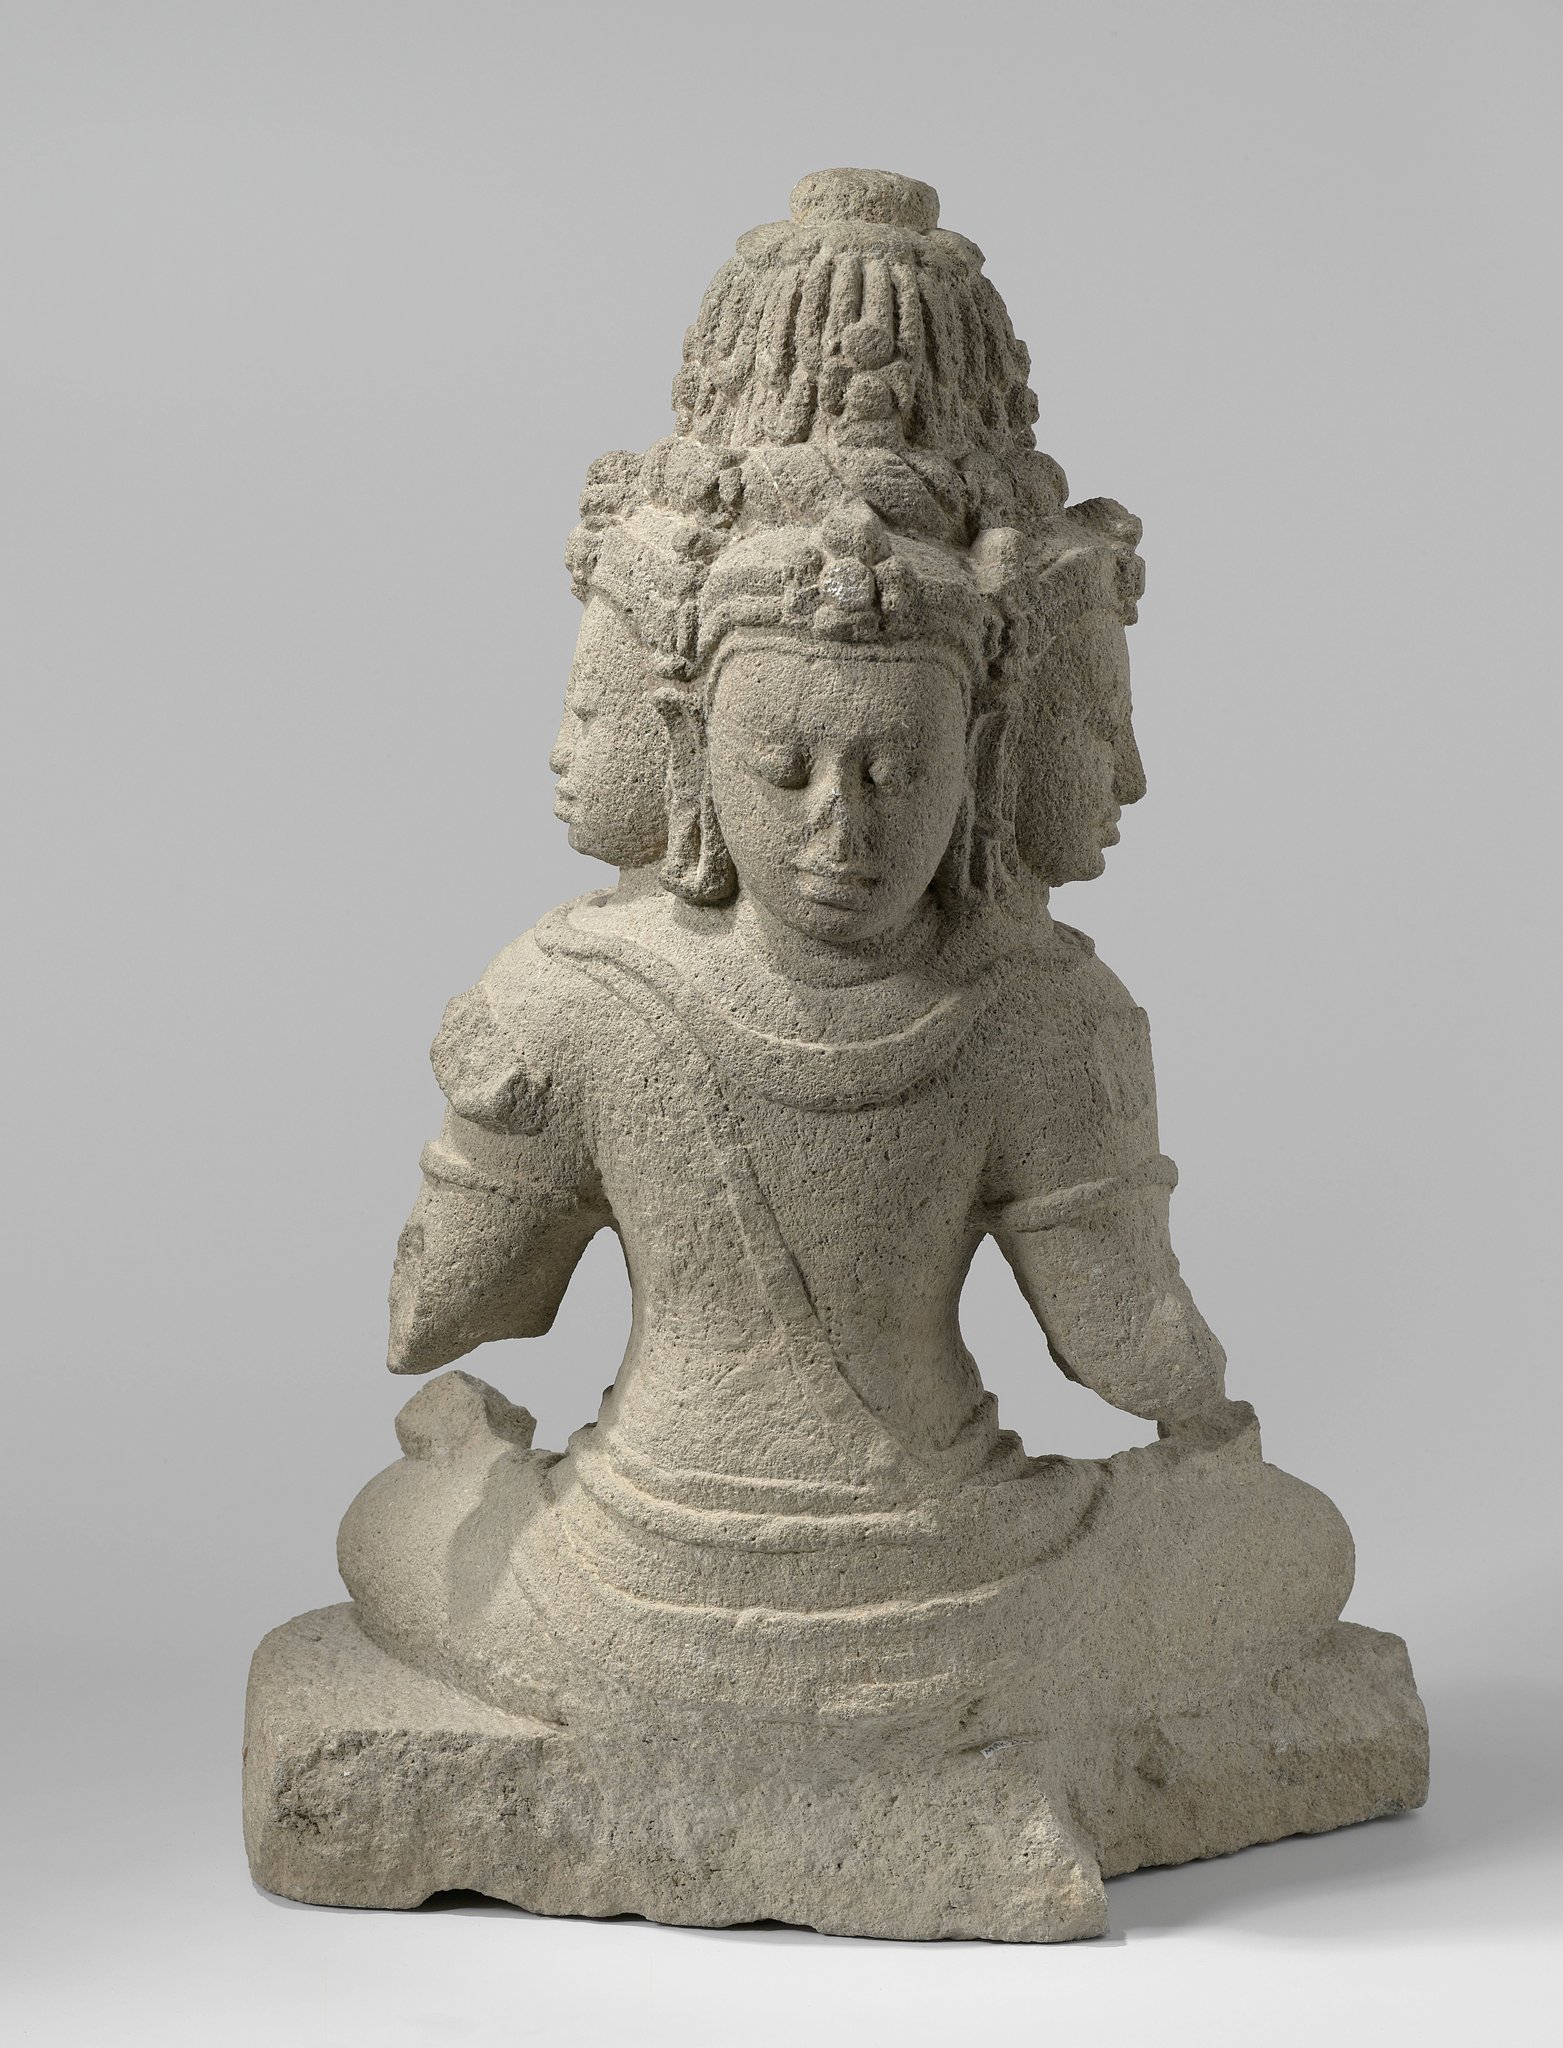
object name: sculpture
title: Brahma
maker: Anonymous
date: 800-900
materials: stone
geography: candi merak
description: The Hindu deity Brahma is easy to recognize by his four faces, each directed toward one of the four cardinal directions. He is revered as the creator of the universe and is often part of the group of supreme deities who are venerated along with the great god Shiva. This sculpture is from Candi Merak, a temple of Shiva in Central Java. It was found in two pieces and restored in 1925-1926.